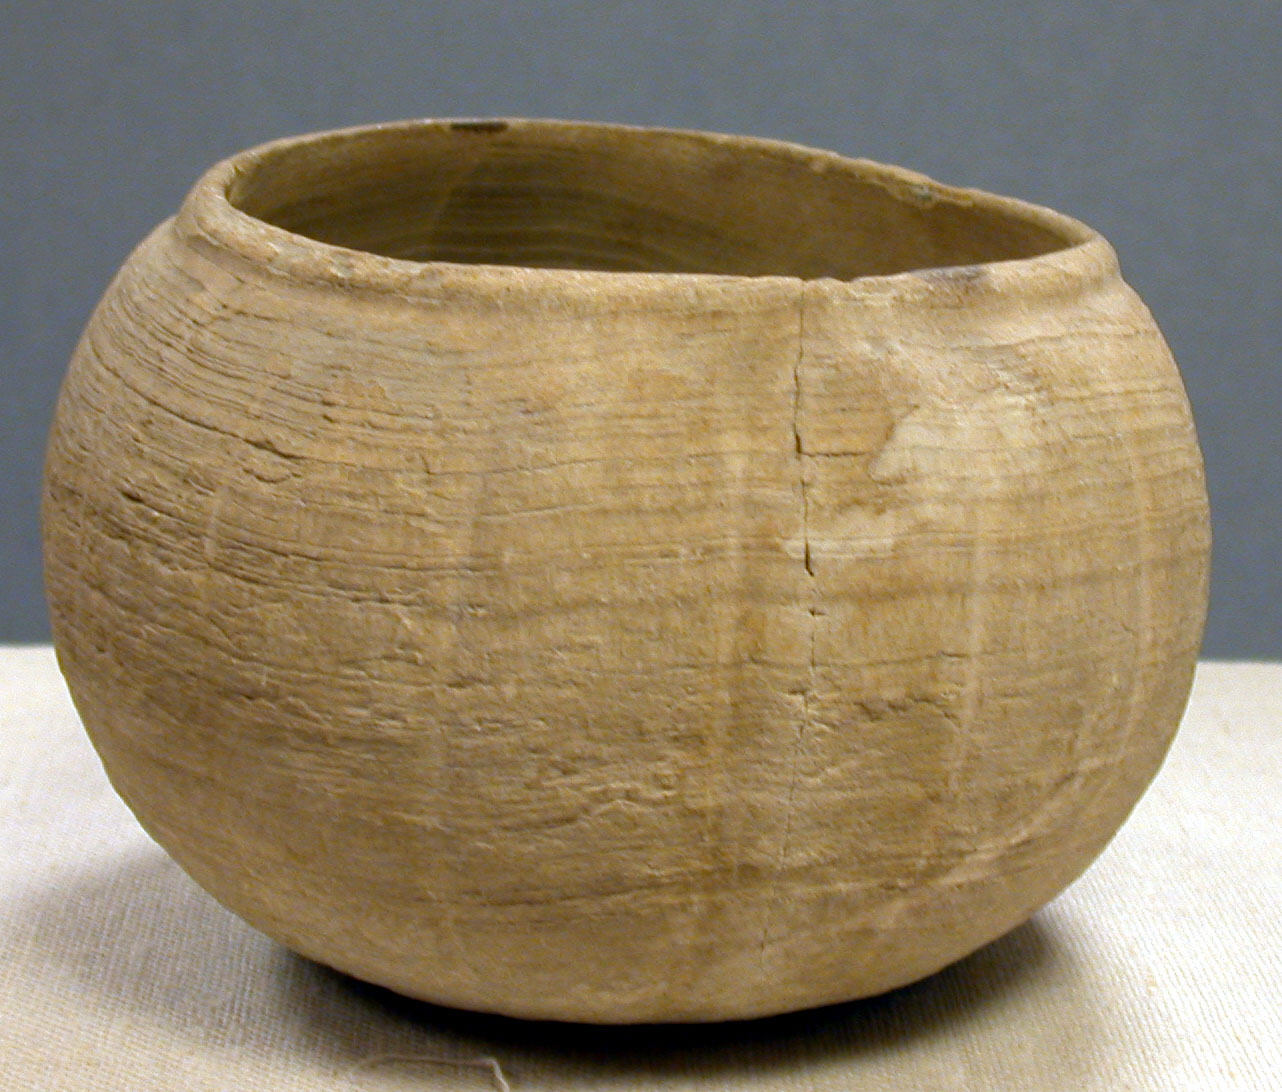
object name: bowl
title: Onyx Bowl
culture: mexican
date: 1501-1600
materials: marble, onyx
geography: mexico